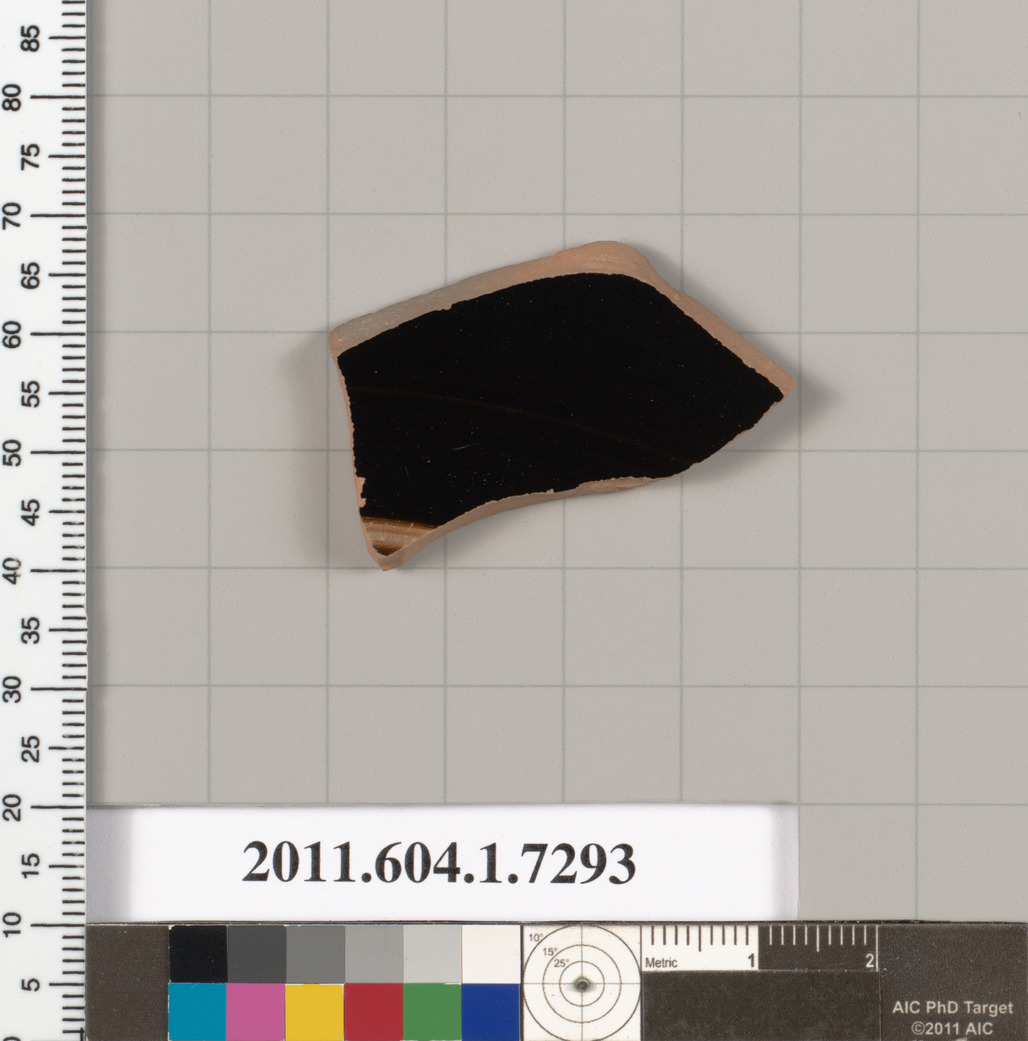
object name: kylix fragment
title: Terracotta fragment of a kylix (drinking cup)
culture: greek, attic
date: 500-480 BCE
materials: terracotta